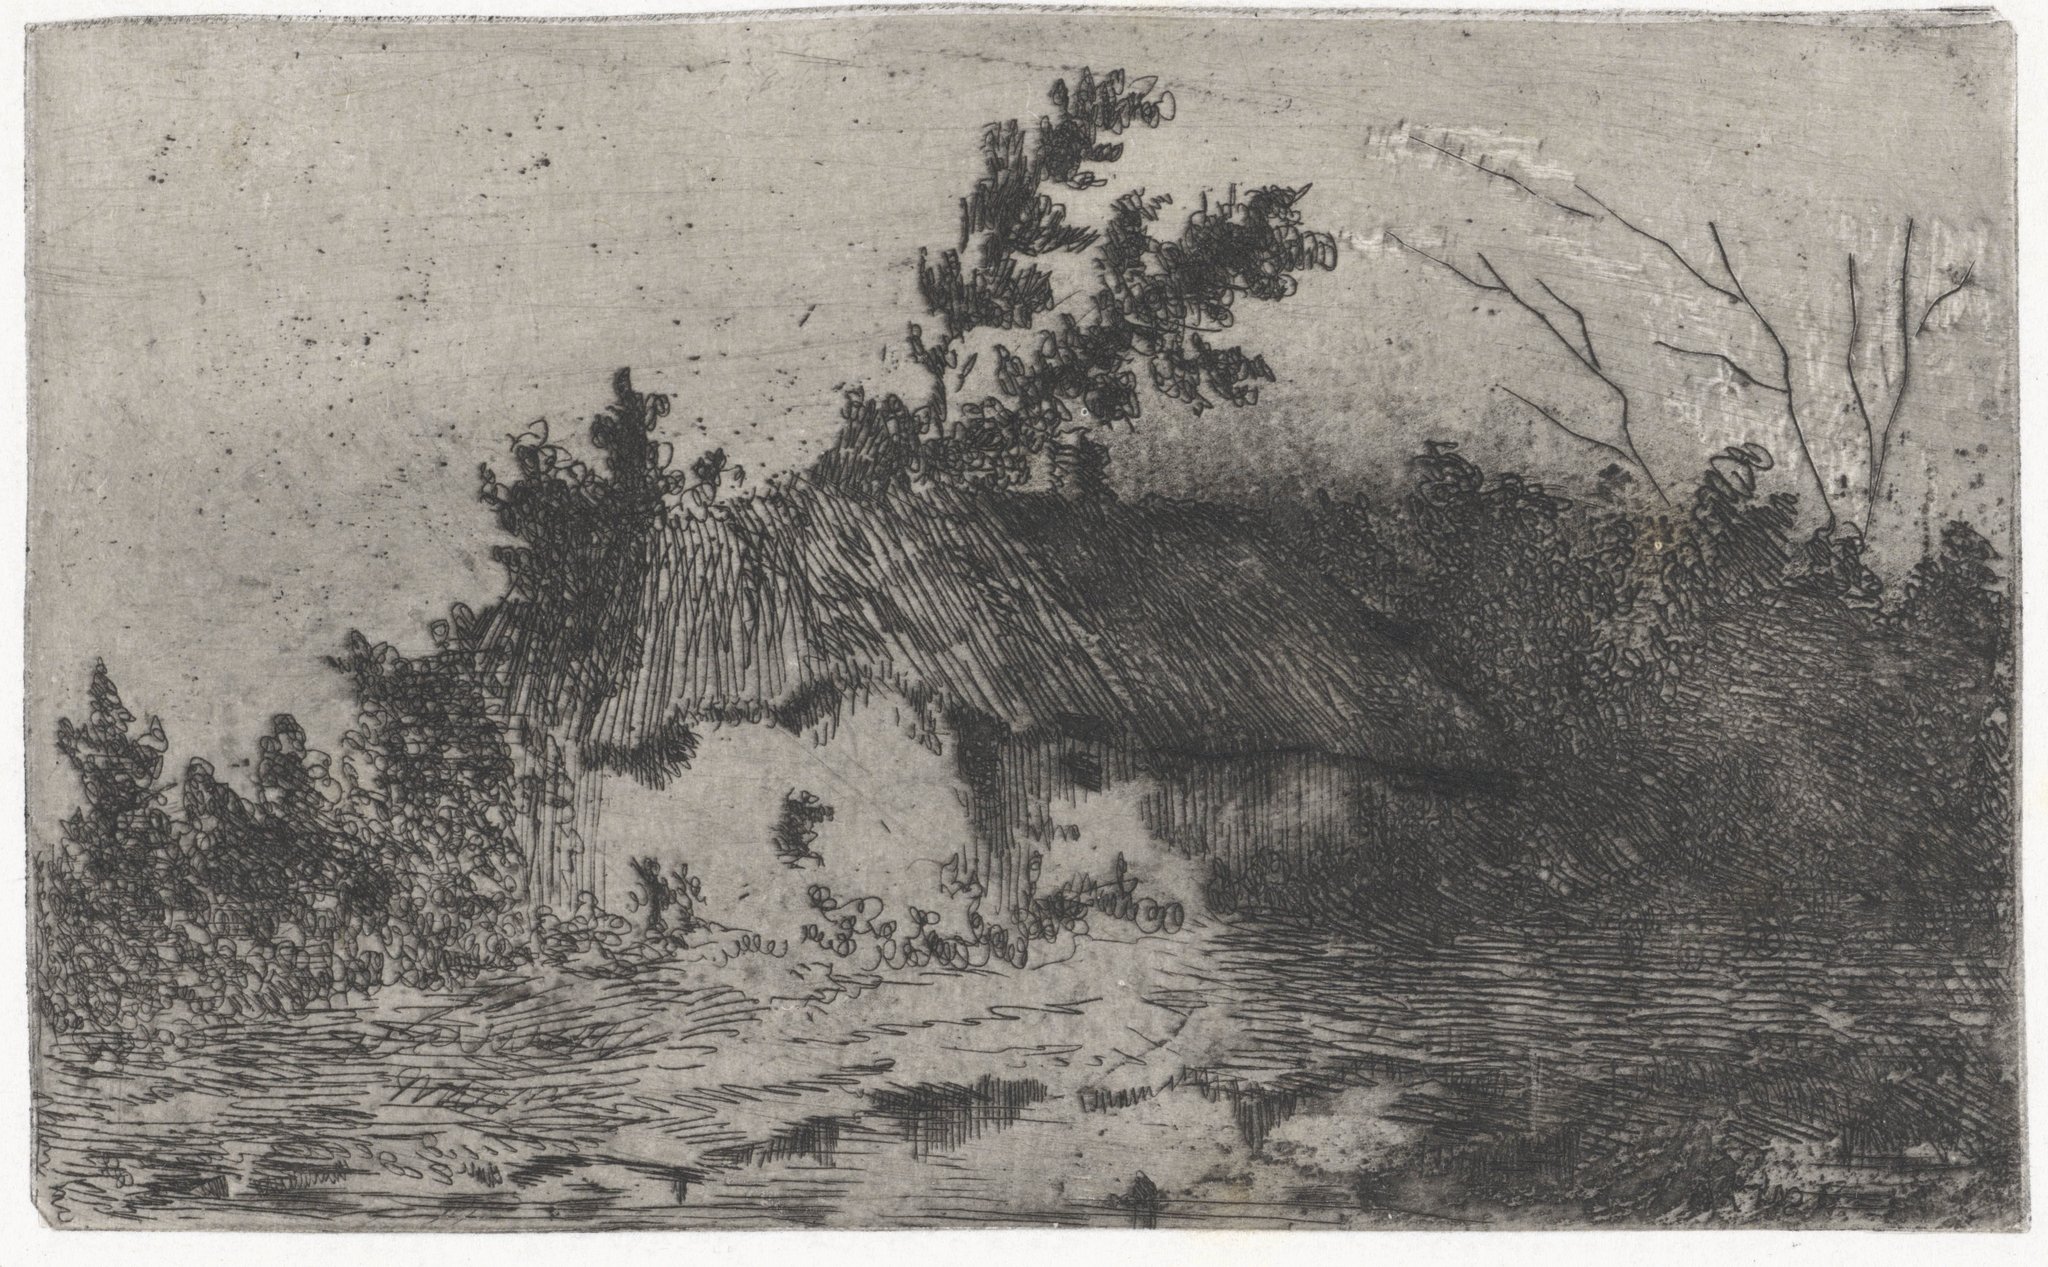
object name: print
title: Hut met rieten dak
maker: arnoud schaepkens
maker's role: print maker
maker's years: 1816-1904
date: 1831-1904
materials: paper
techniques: drypoint, etching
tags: cottage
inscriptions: collector's mark: Lugt 2228